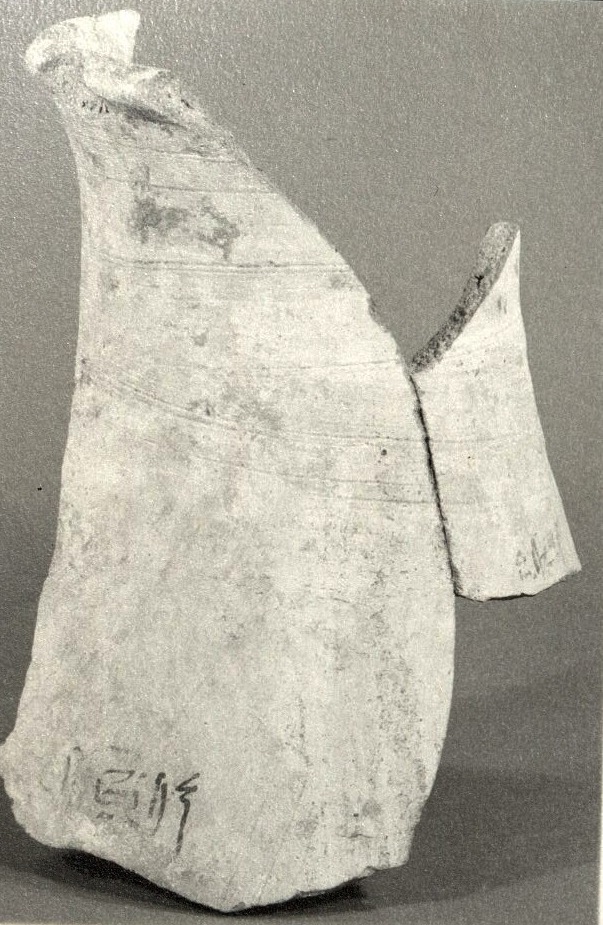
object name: jar label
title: Inscribed Pot Fragment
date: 1580-1479 BCE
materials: ink, pottery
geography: egypt